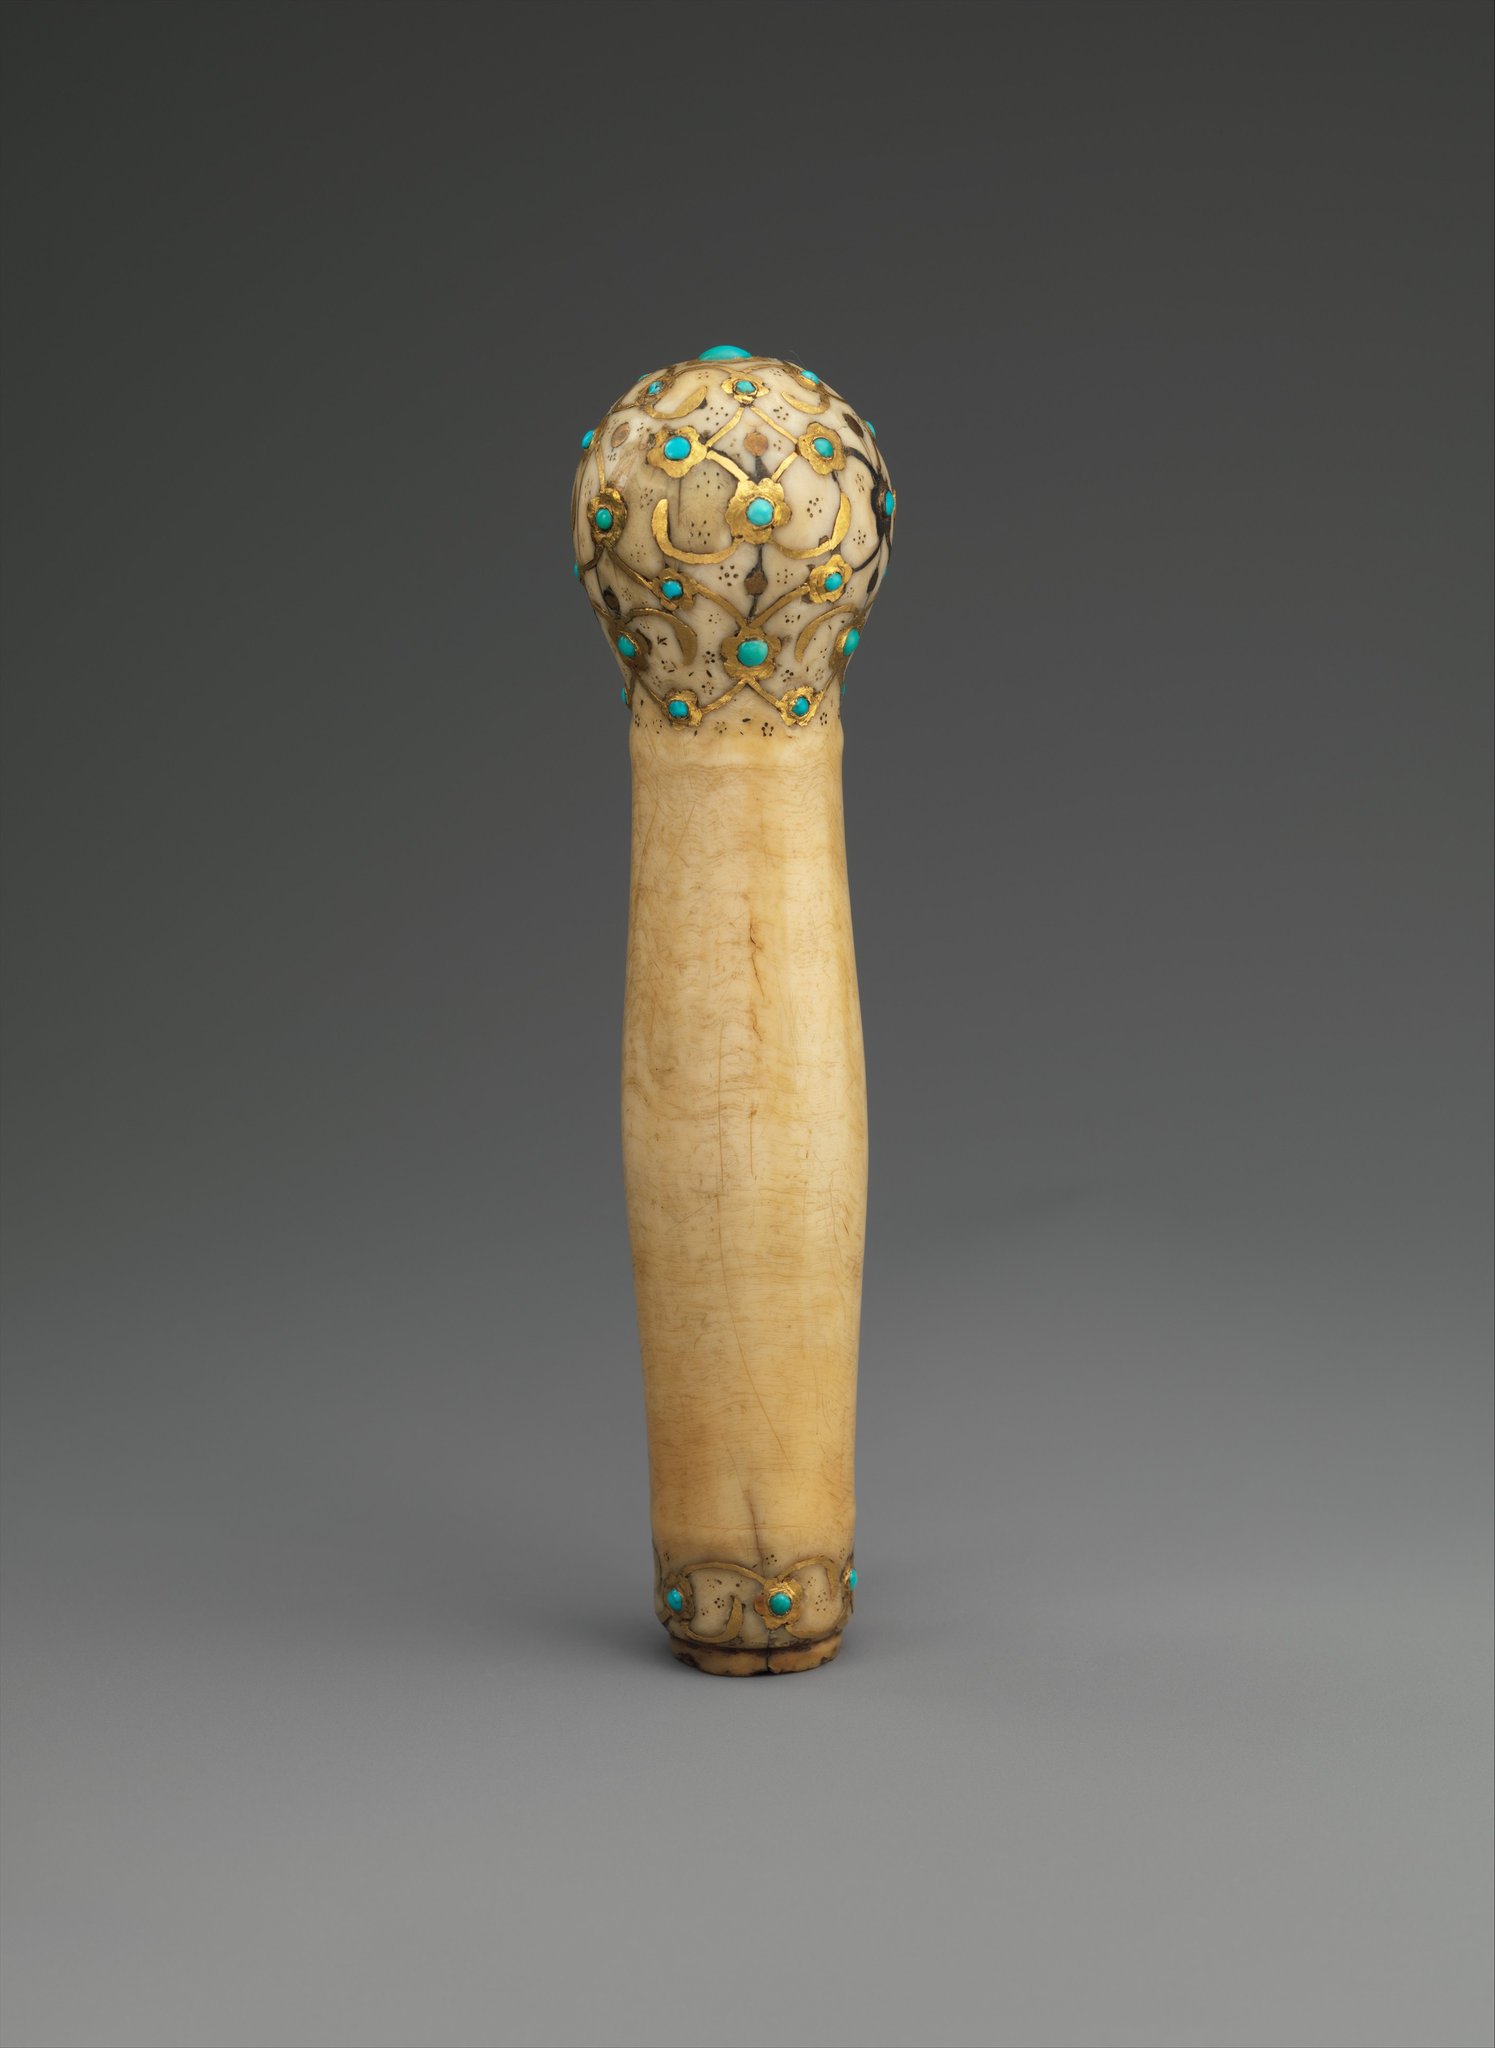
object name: handle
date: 1701-1800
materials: gold, ivory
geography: turkey